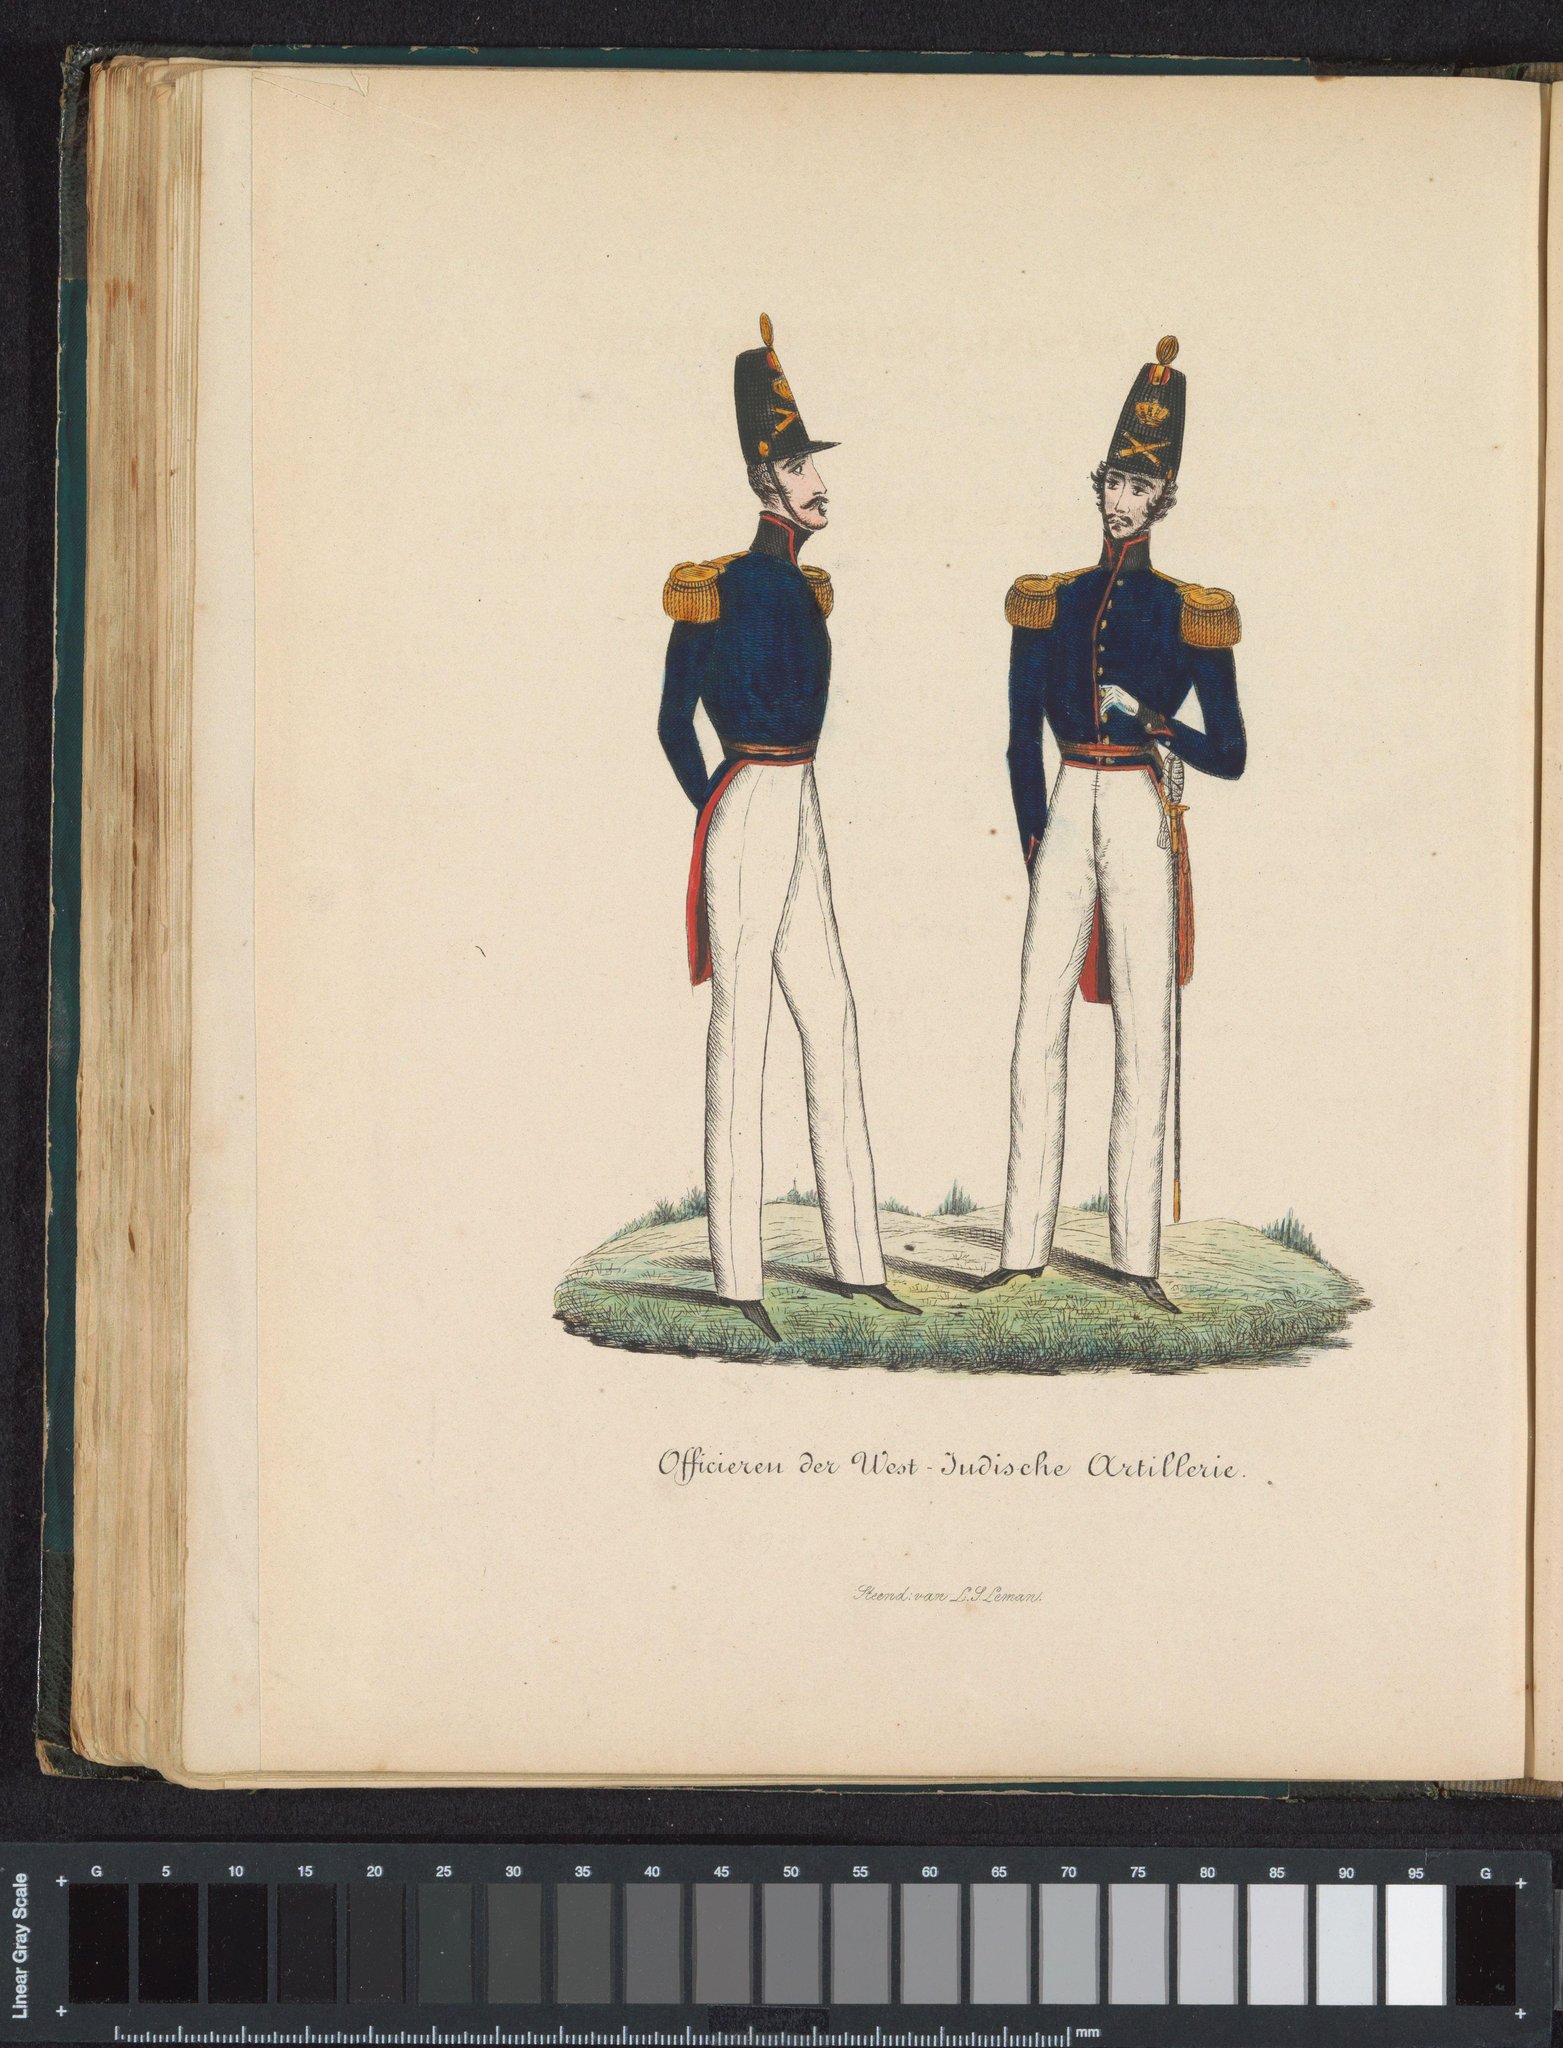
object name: costume print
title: Uniform van de officieren van de artillerie van de West-Indische troepen, 1845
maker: louis salomon leman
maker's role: steendrukker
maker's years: 1818-1889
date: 1845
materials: paper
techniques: hand coloring, lithograph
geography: amsterdam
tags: (military) uniforms, netherlands, suriname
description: Uniform van de officieren van de artillerie van de West-Indische troepen. Illustratie in een boek uit 1845 over de uniformen en kledingstukken van de Nederlandse land-, zeemacht en schutterijen in Nederland en in de overzeese gebiedsdelen.